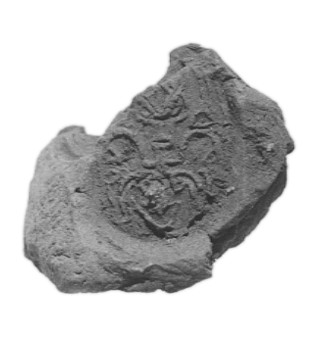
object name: sealing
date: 2030-1640 BCE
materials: clay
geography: egypt